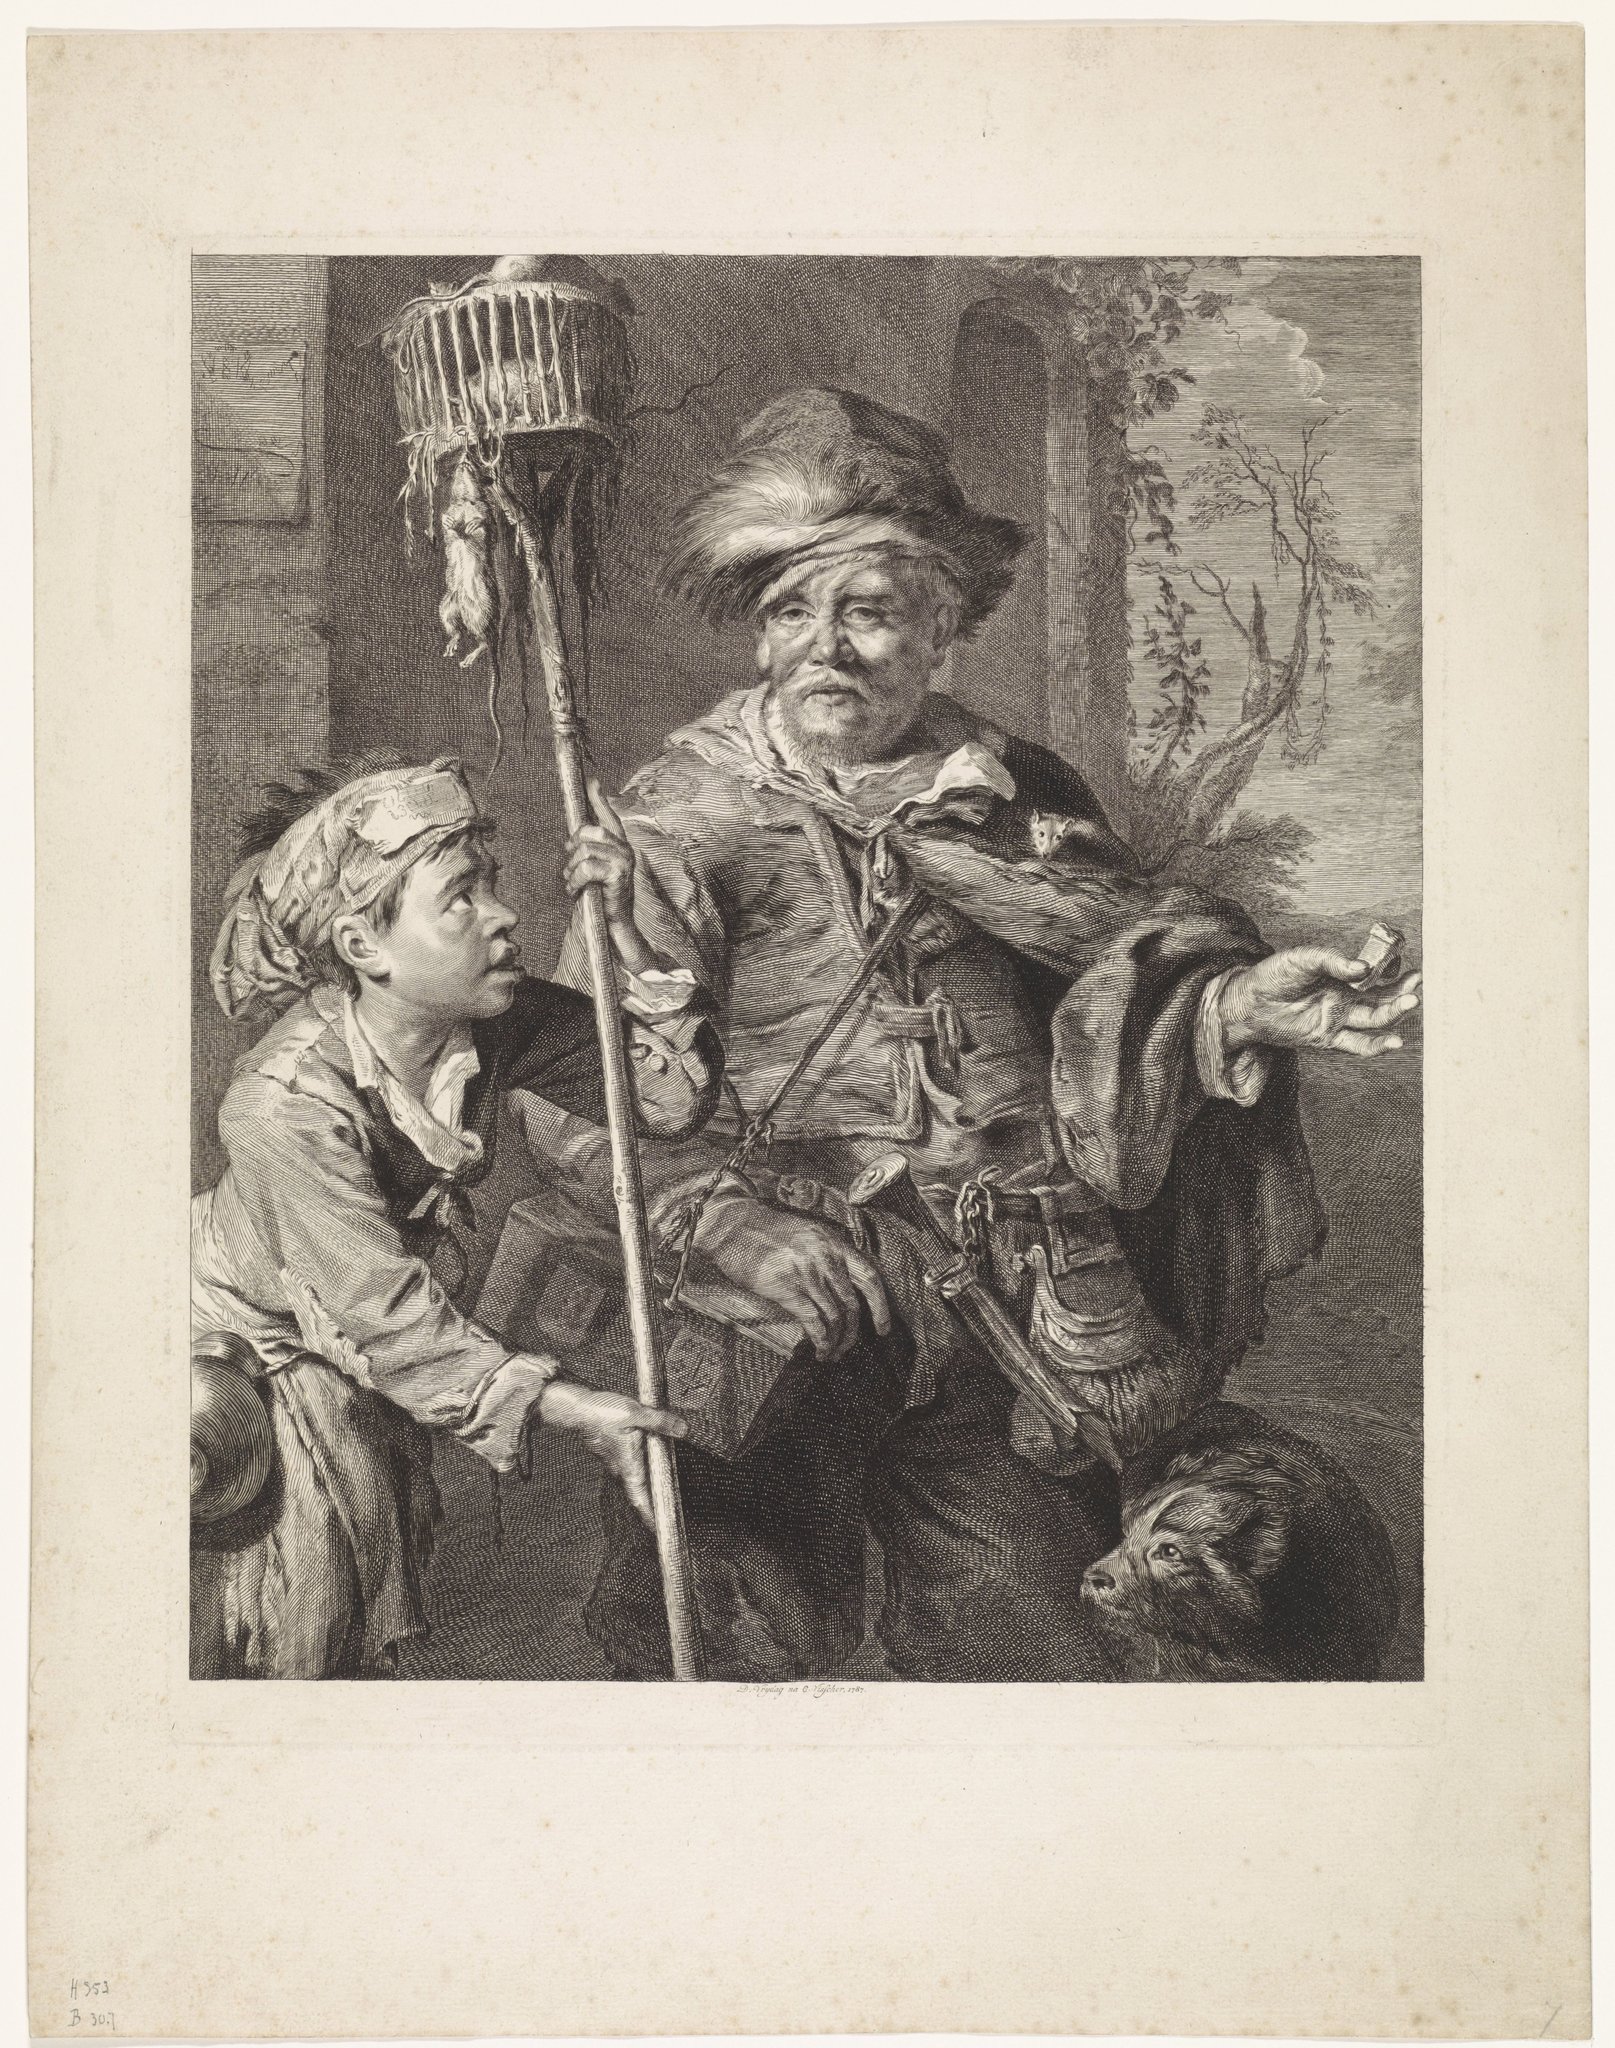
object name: print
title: De rattenvanger met zijn knecht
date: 1787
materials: paper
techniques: engraving, etching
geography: the hague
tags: rat exterminator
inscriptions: collector's mark: Lugt 2228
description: Een rattenvanger met zijn hond en knecht. De jongen houdt een staf met een rattenkooi vast. De rattenvanger draagt een tas en gereedschap met zich mee, op zijn mantel loopt een rat.